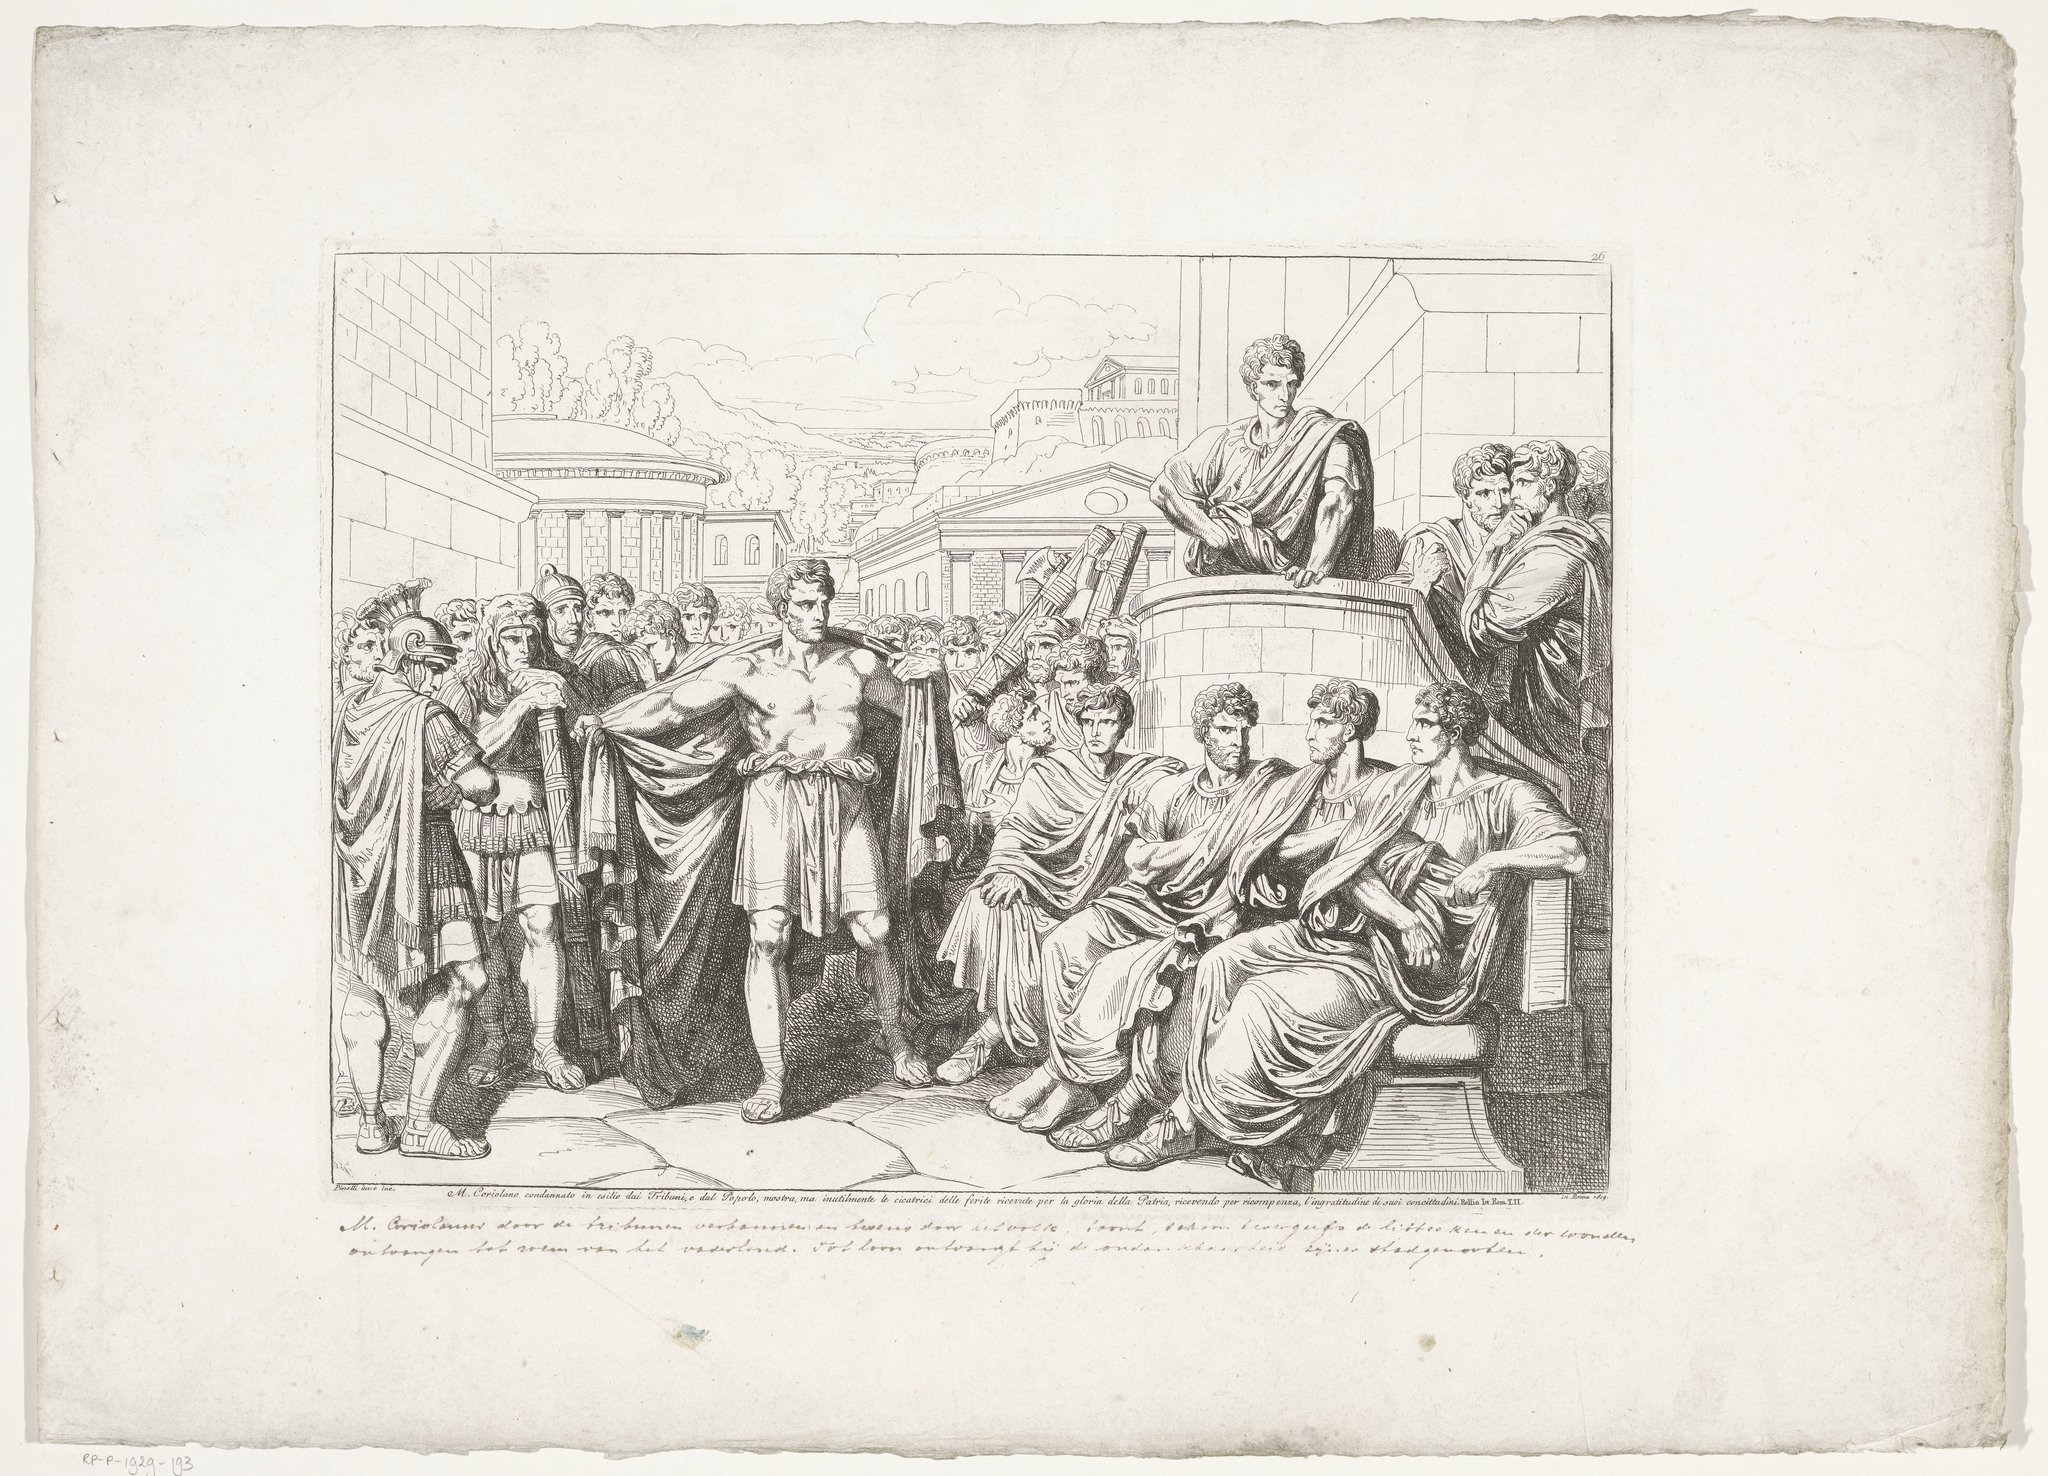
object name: print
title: Geschiedenis van het Romeinse Rijk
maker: bartolomeo pinelli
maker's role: draughtsman, print maker, sculptor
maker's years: 1781-1835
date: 1819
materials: paper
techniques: etching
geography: rome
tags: (story of) coriolanus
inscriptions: collector's mark: Lugt 2228, inscription: ‘M. Coriolanus door de tribunen verbannen en tevens door het volk, toont, schoon tevergeefs de litteekenen der...’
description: Gaius Marcius Coriolanus is zojuist uit Rome verbannen. Hij toont het tribunaal en het volk van Rome tevergeefs zijn littekens die hij heeft opgelopen toen hij vocht voor zijn vaderland.